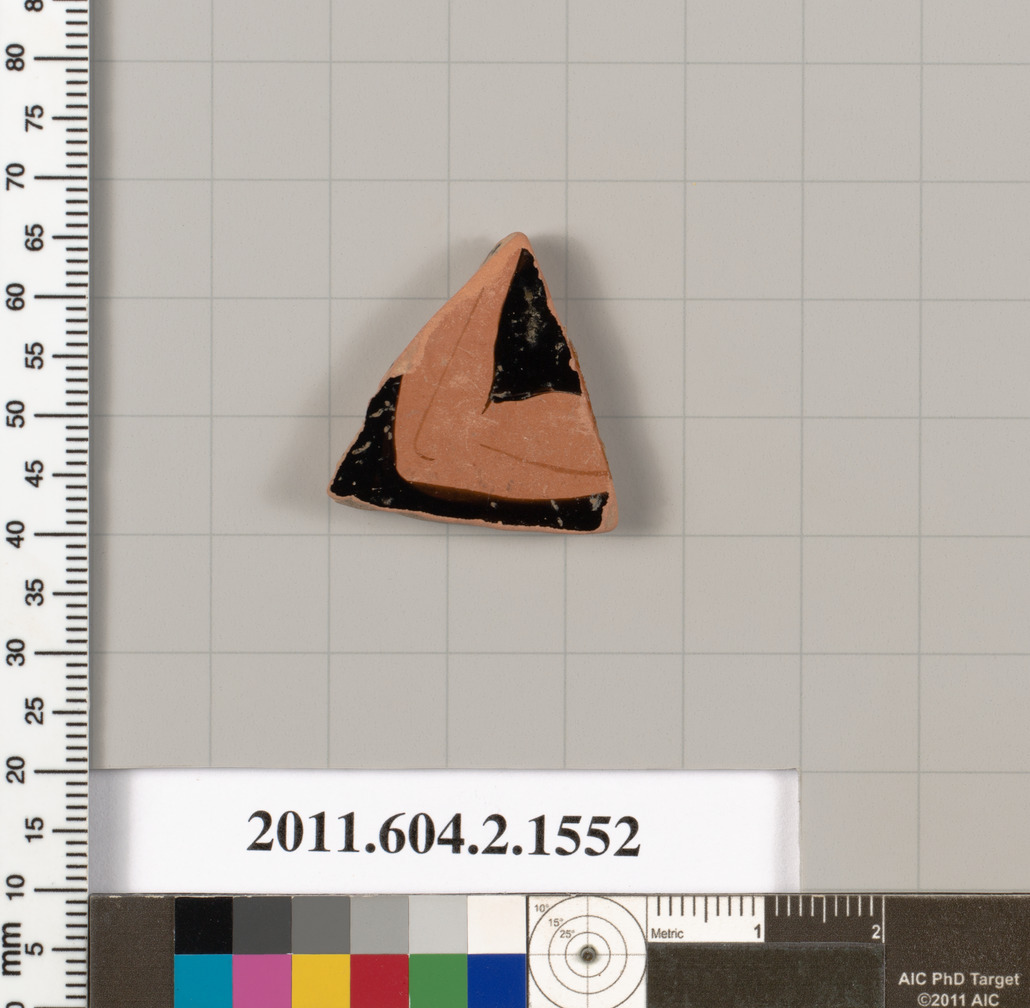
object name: skyphos fragment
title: Terracotta fragment of a skyphos (deep drinking cup)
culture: greek, attic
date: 460-440 BCE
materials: terracotta